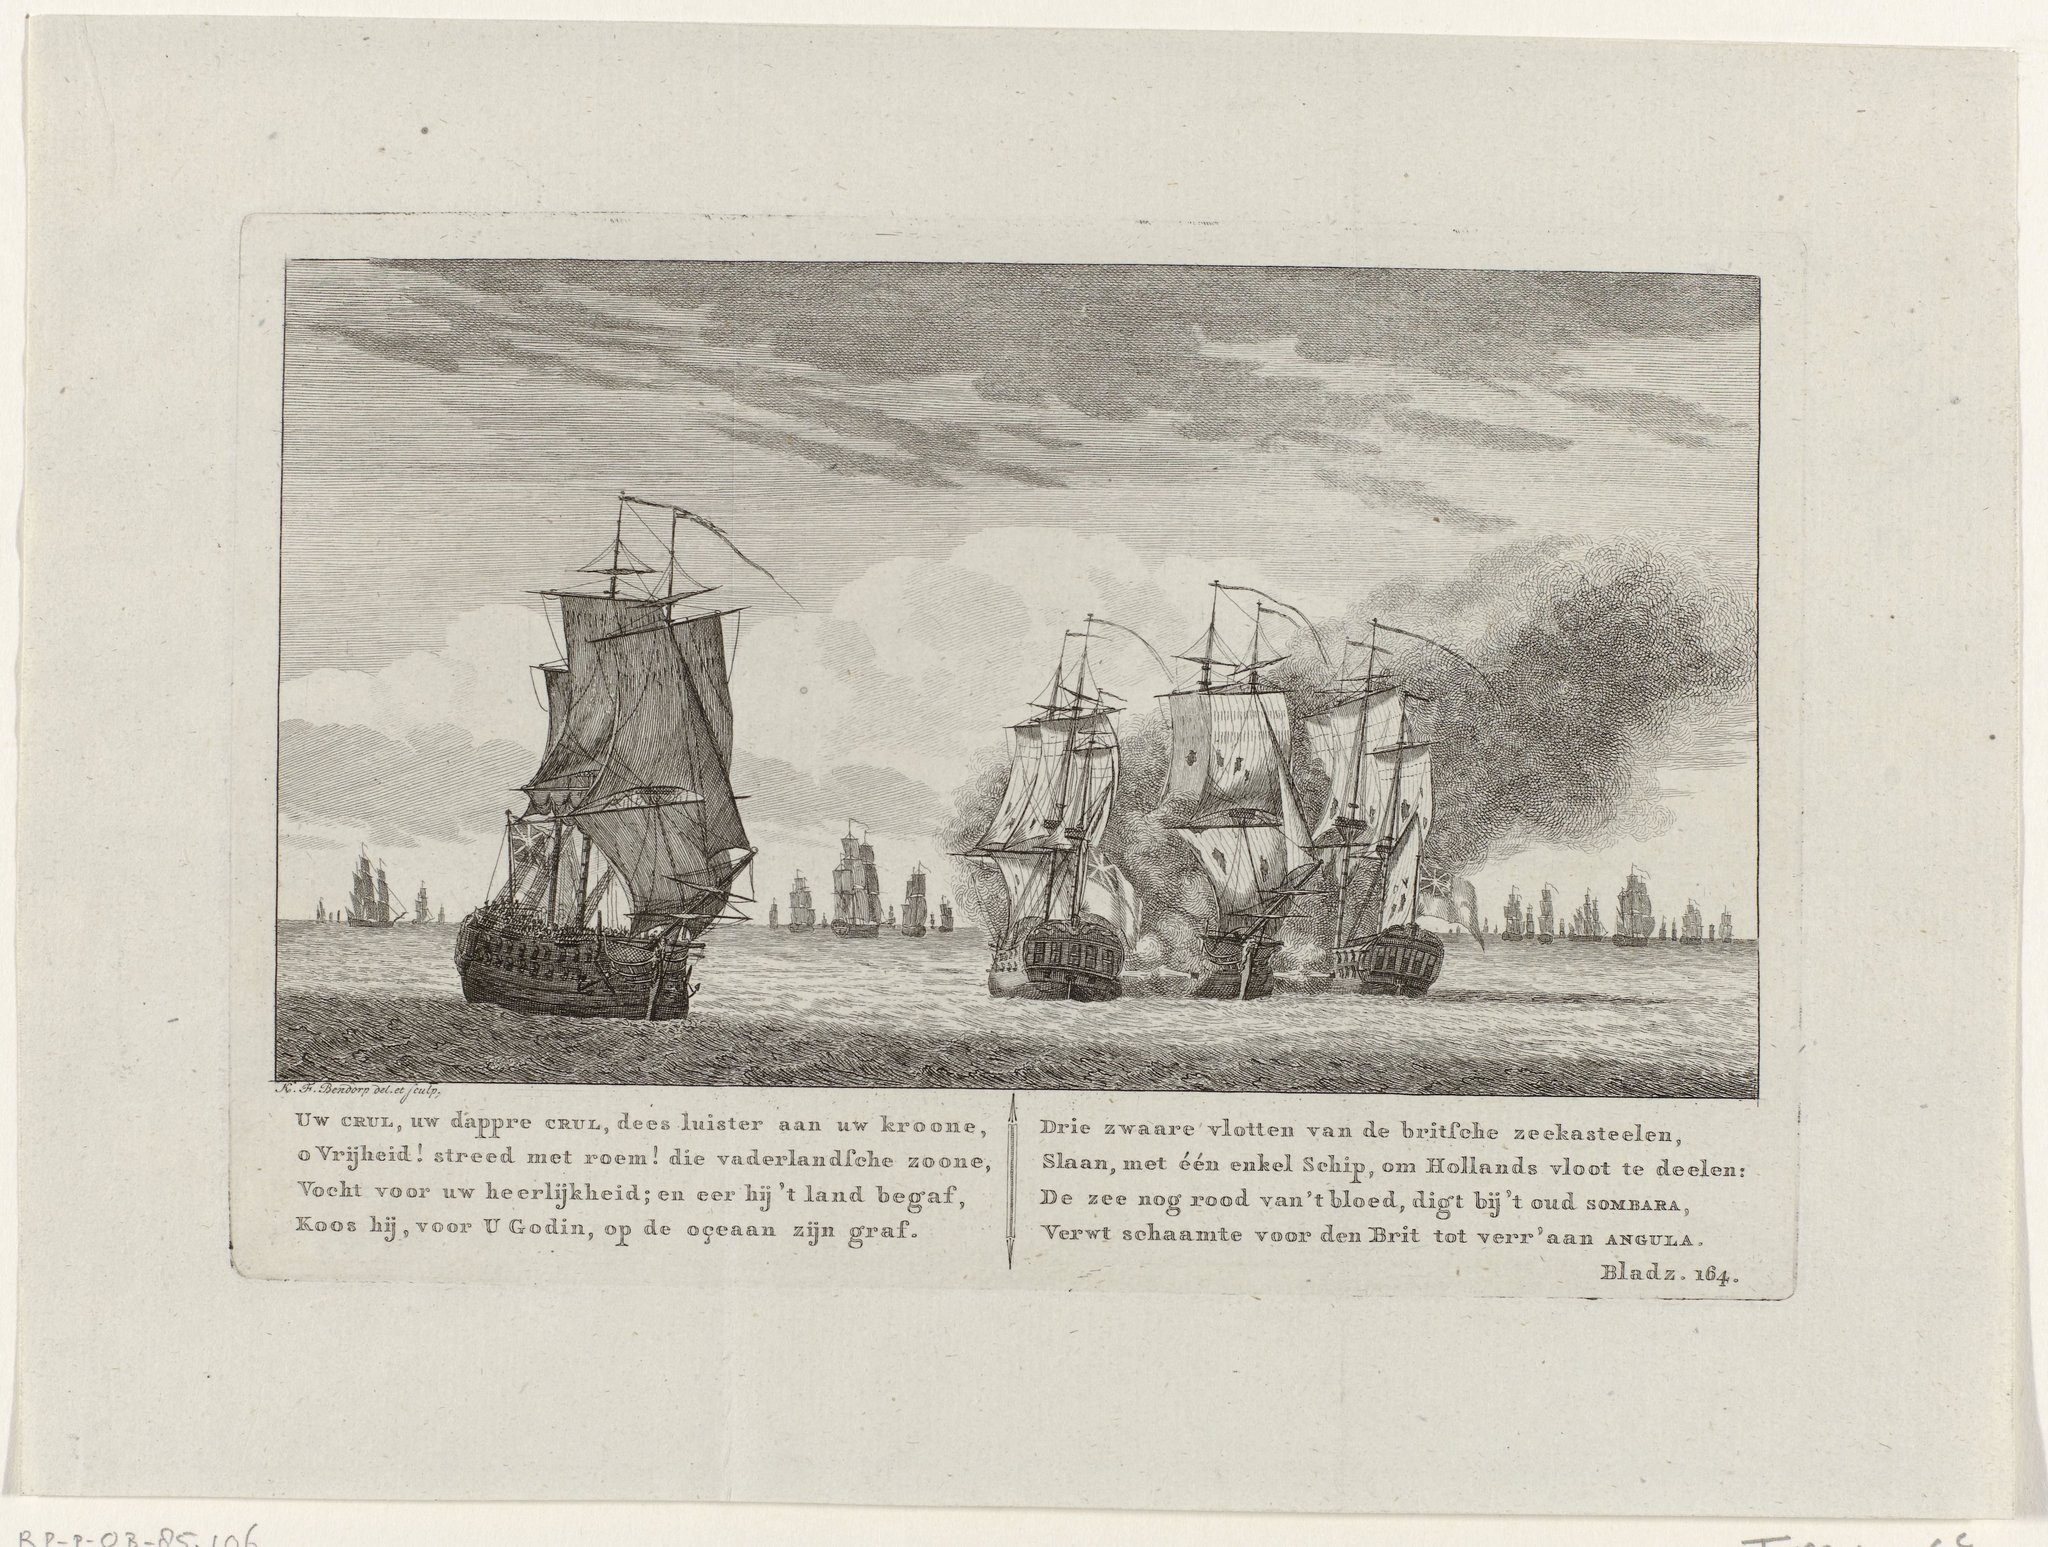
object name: print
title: Willem Crul aangevallen door de Engelsen, 1781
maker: carel frederik bendorp (i)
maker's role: print maker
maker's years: 1736-1814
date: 1781-1782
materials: paper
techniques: engraving, etching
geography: northern netherlands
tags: haarlem, battle (+ naval force)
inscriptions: collector's mark: Lugt 2228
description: Het Nederlandse oorlogsschip Mars onder bevel van schout-bij-nacht Willem Crul aangevallen door drie Engelse oorlogsschepen op 4 februari 1781. De Mars begeleidde een konvooi Nederlandse koopvaarders van Sint-Eustatius. In het onderschrift een achtregelig vers en verwijzing naar bladz. 164.